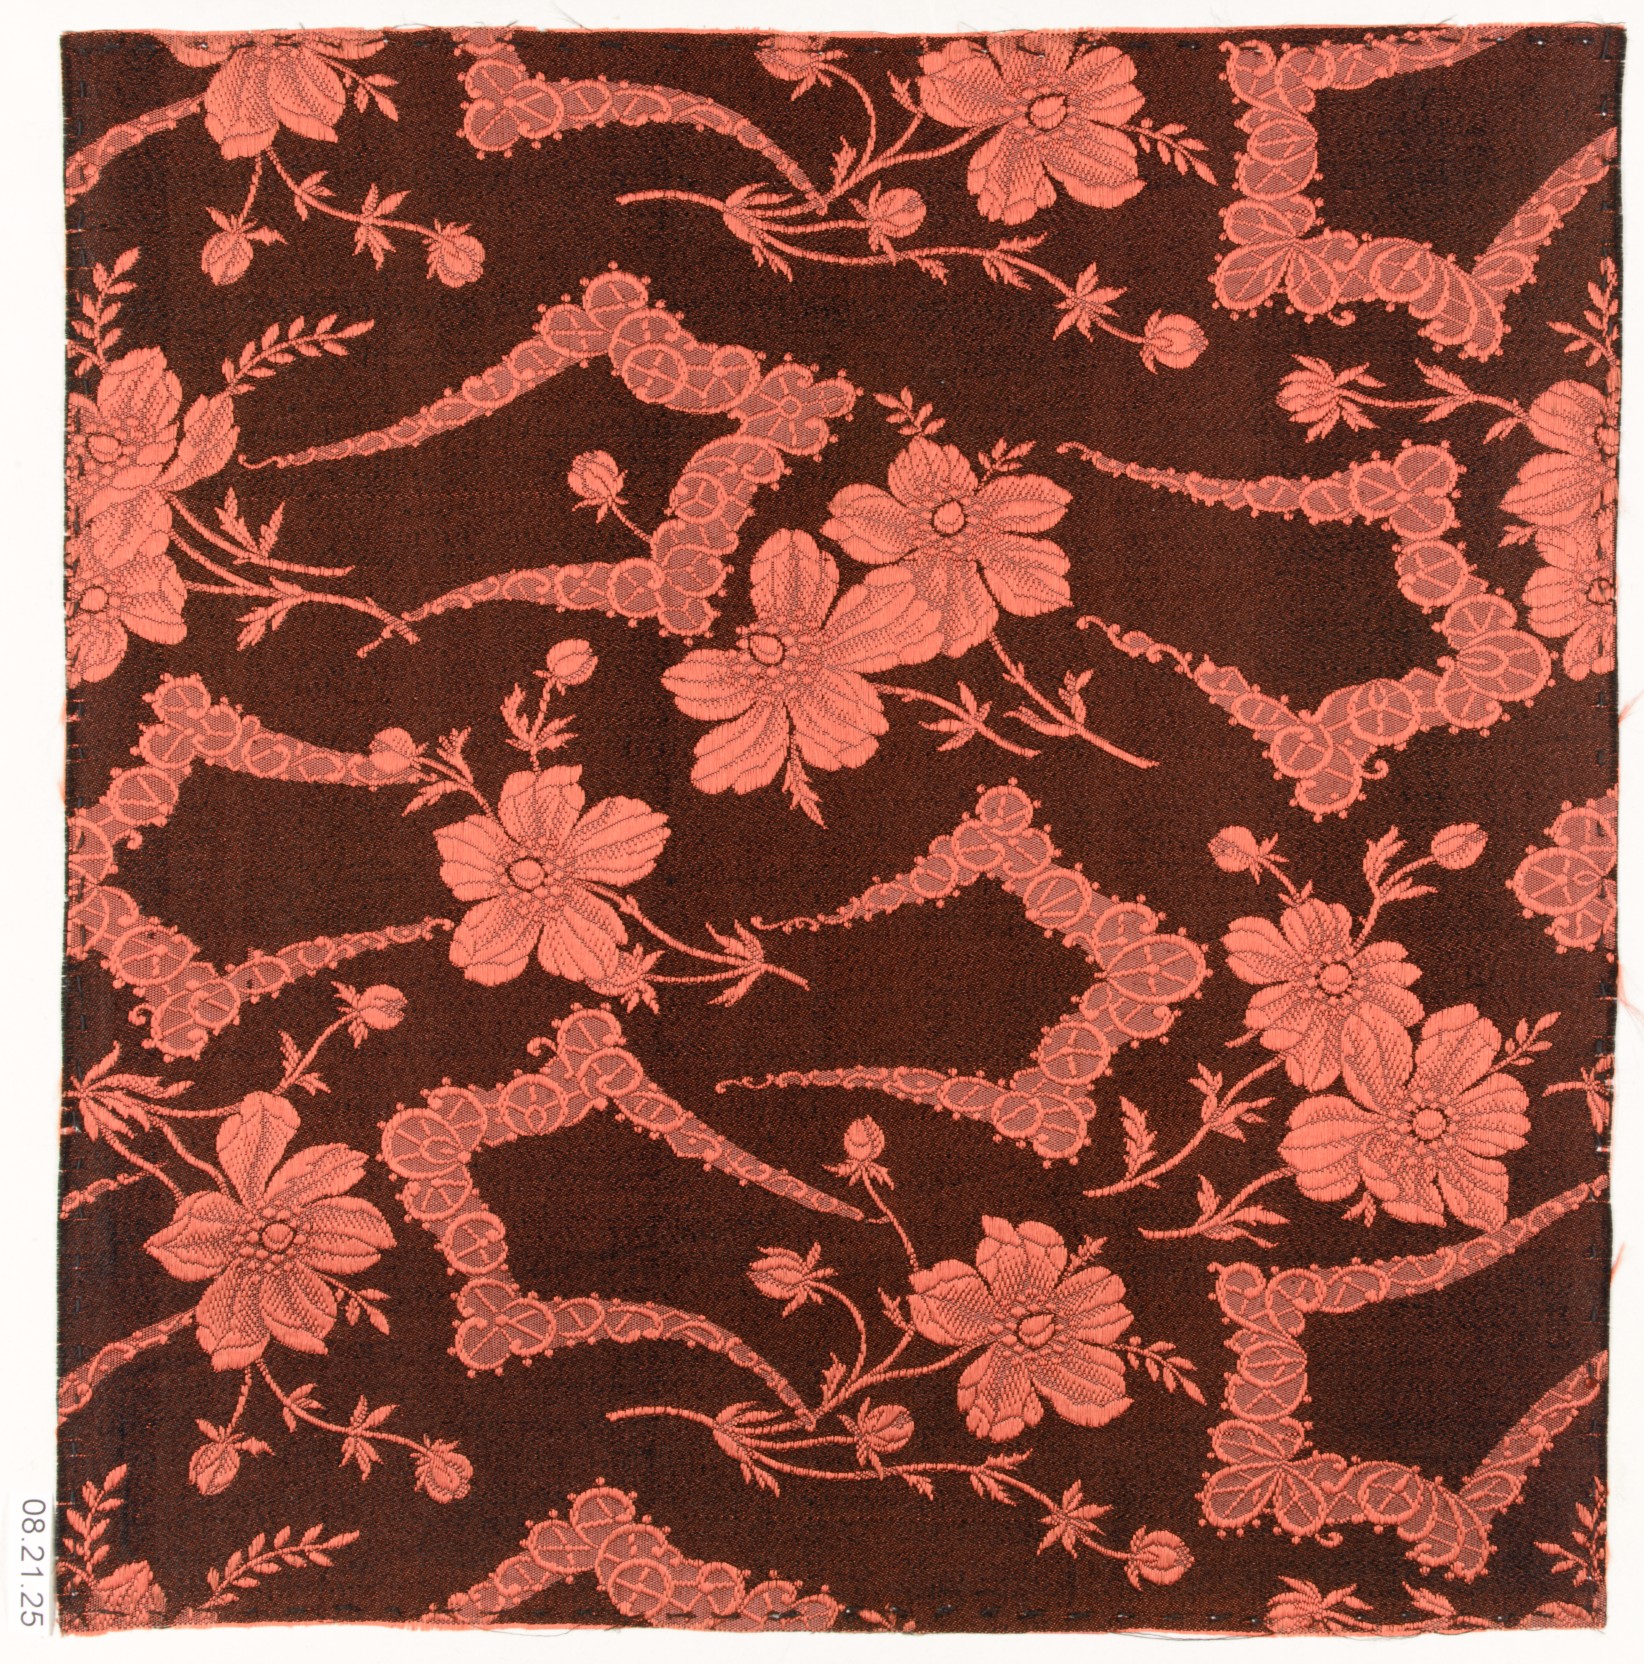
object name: textile sample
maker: Anonymous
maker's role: designer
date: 1900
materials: silk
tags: flowers